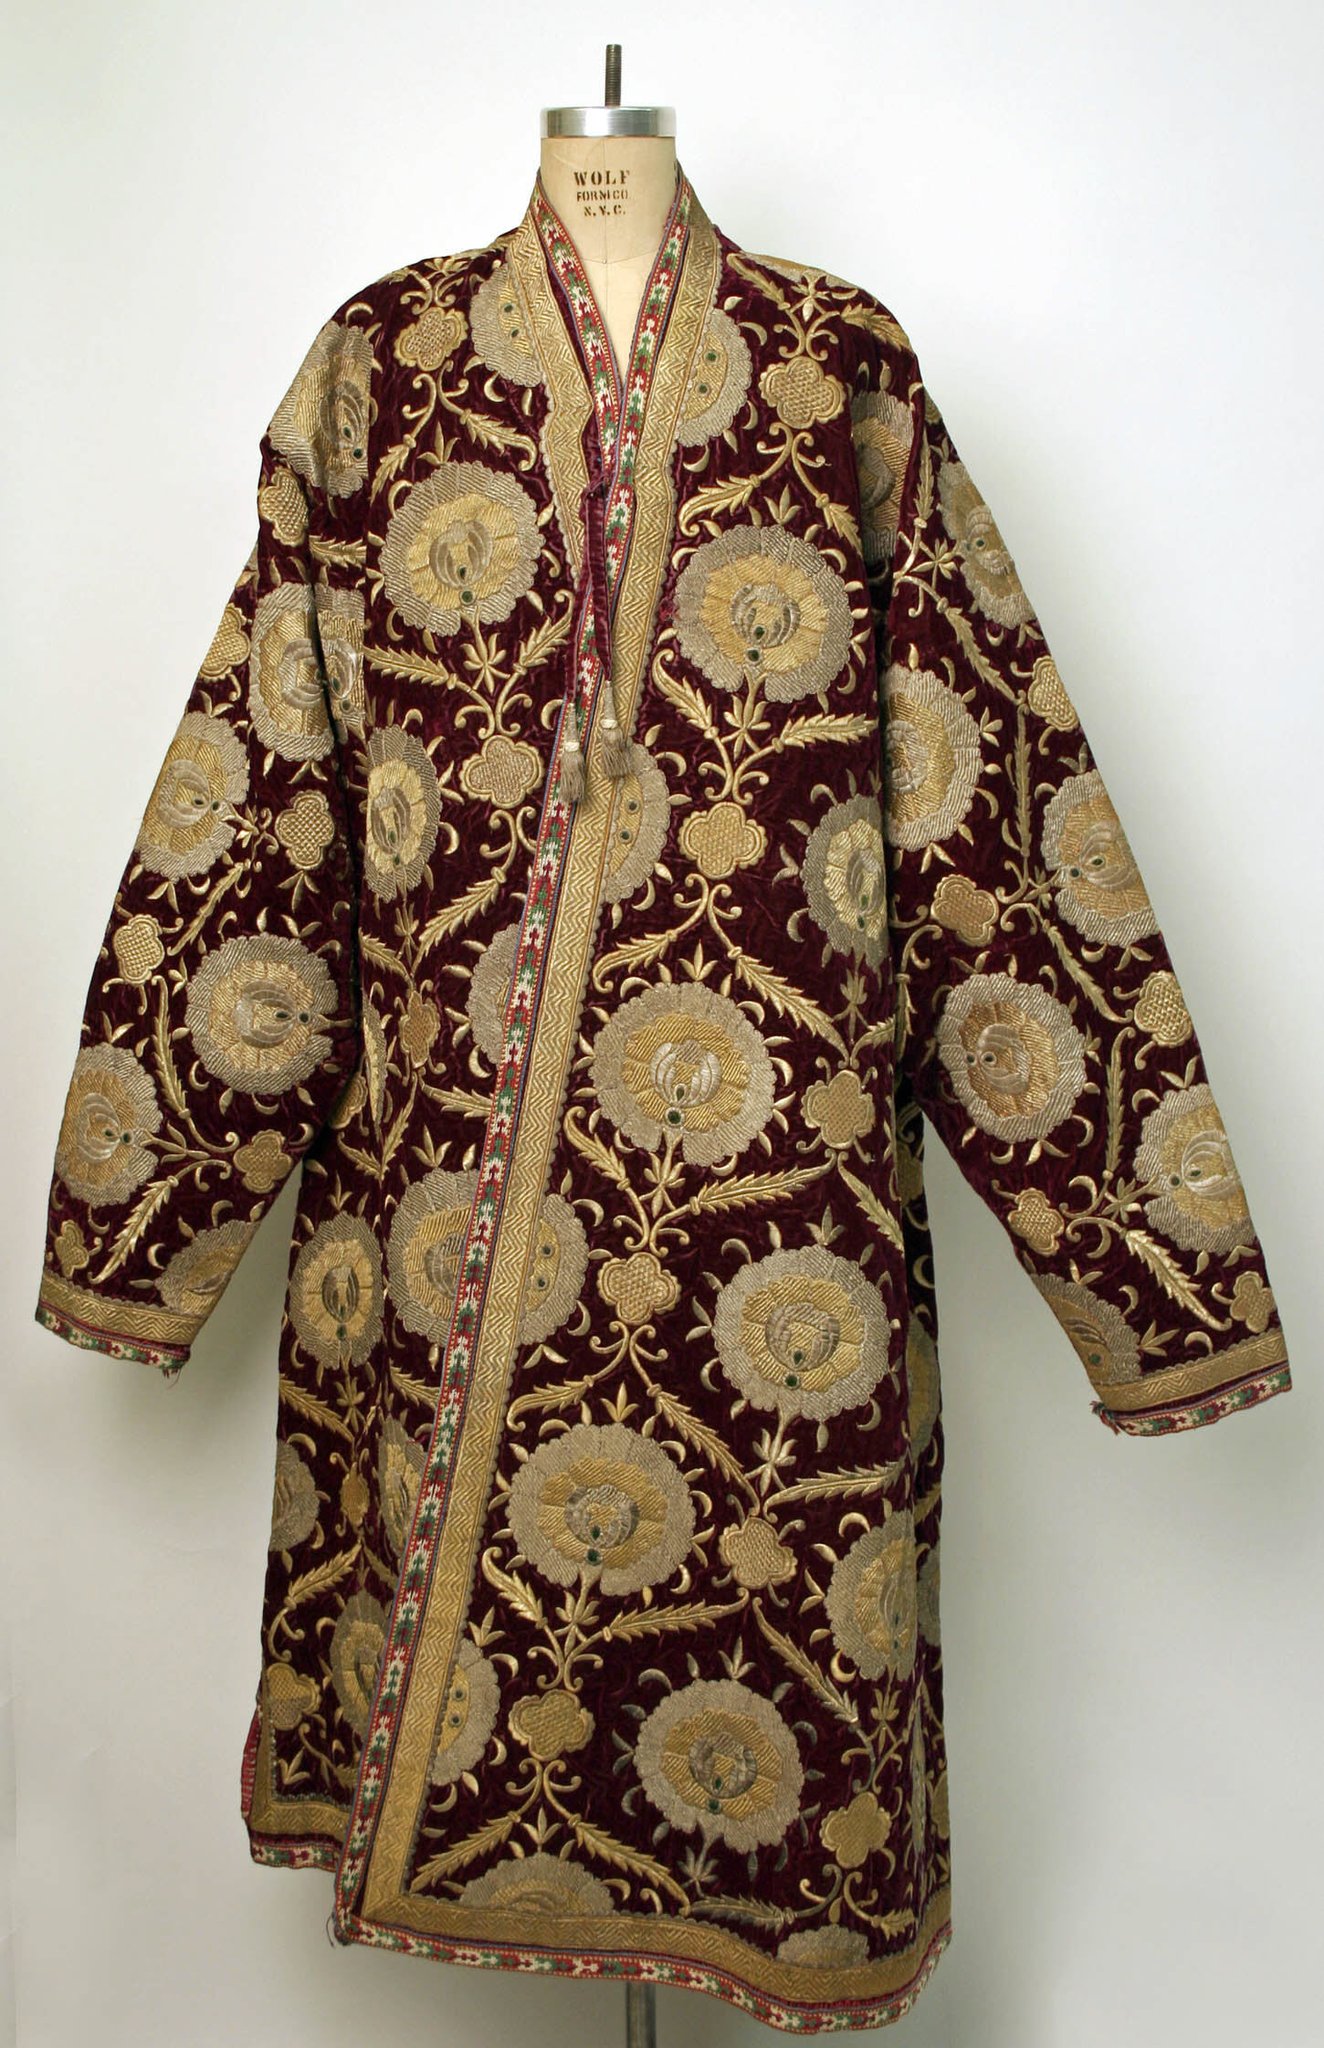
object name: kaftan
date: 1767-1833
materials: metal thread, silk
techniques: embroidery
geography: uzbekistan